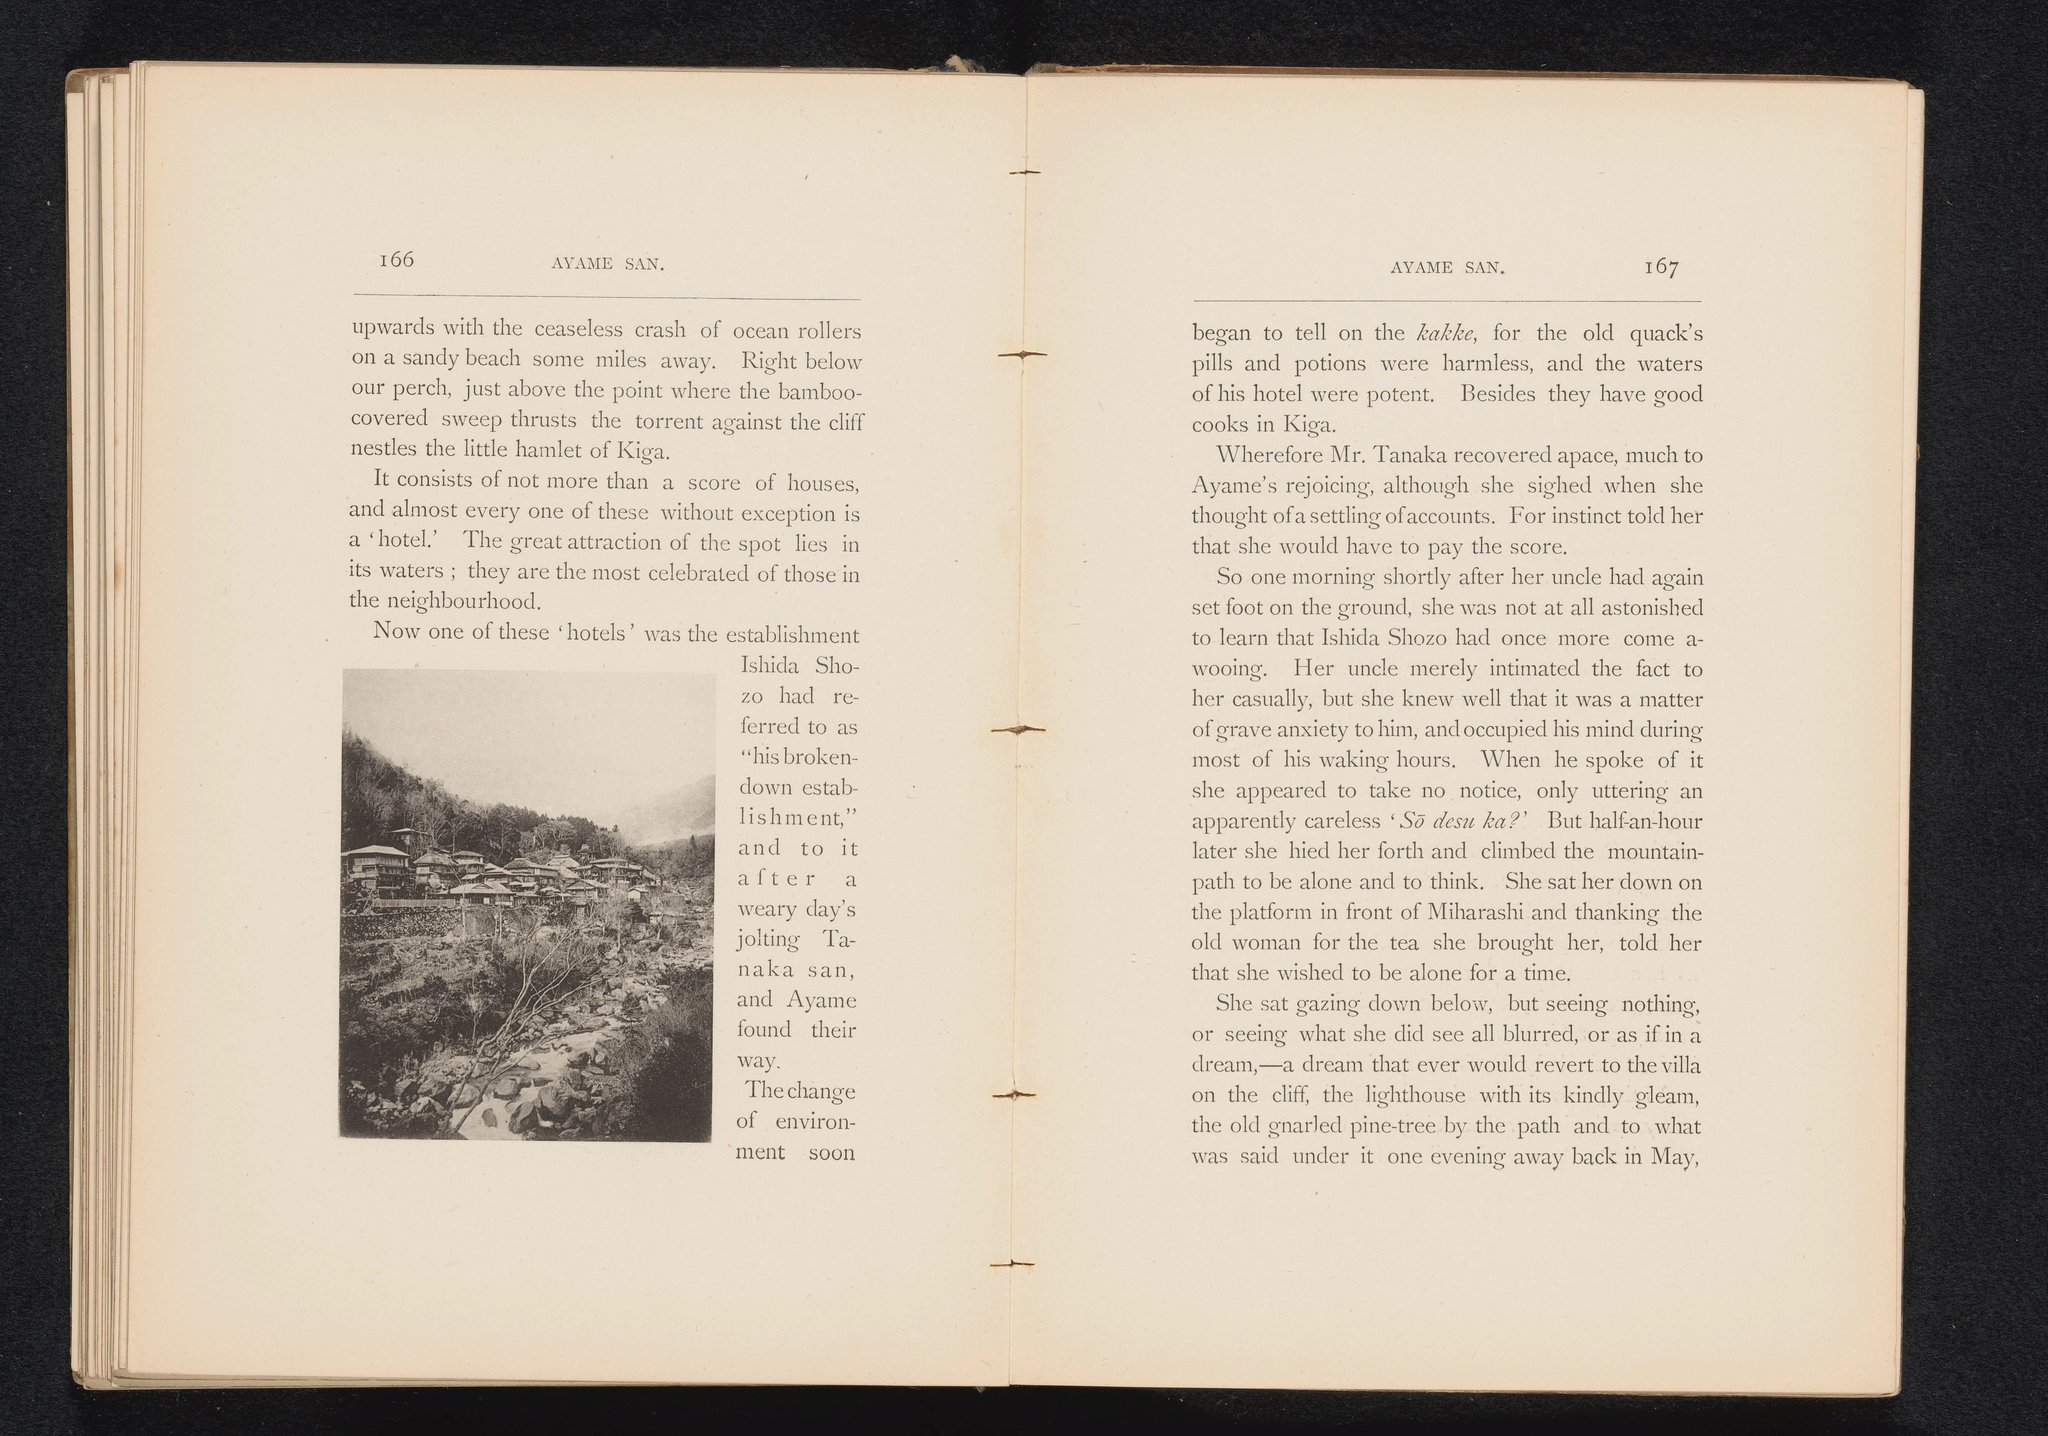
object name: page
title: Gezicht op een dorp te Japan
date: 1882-1892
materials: paper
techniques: photograph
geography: japan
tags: city-view in general; 'veduta'